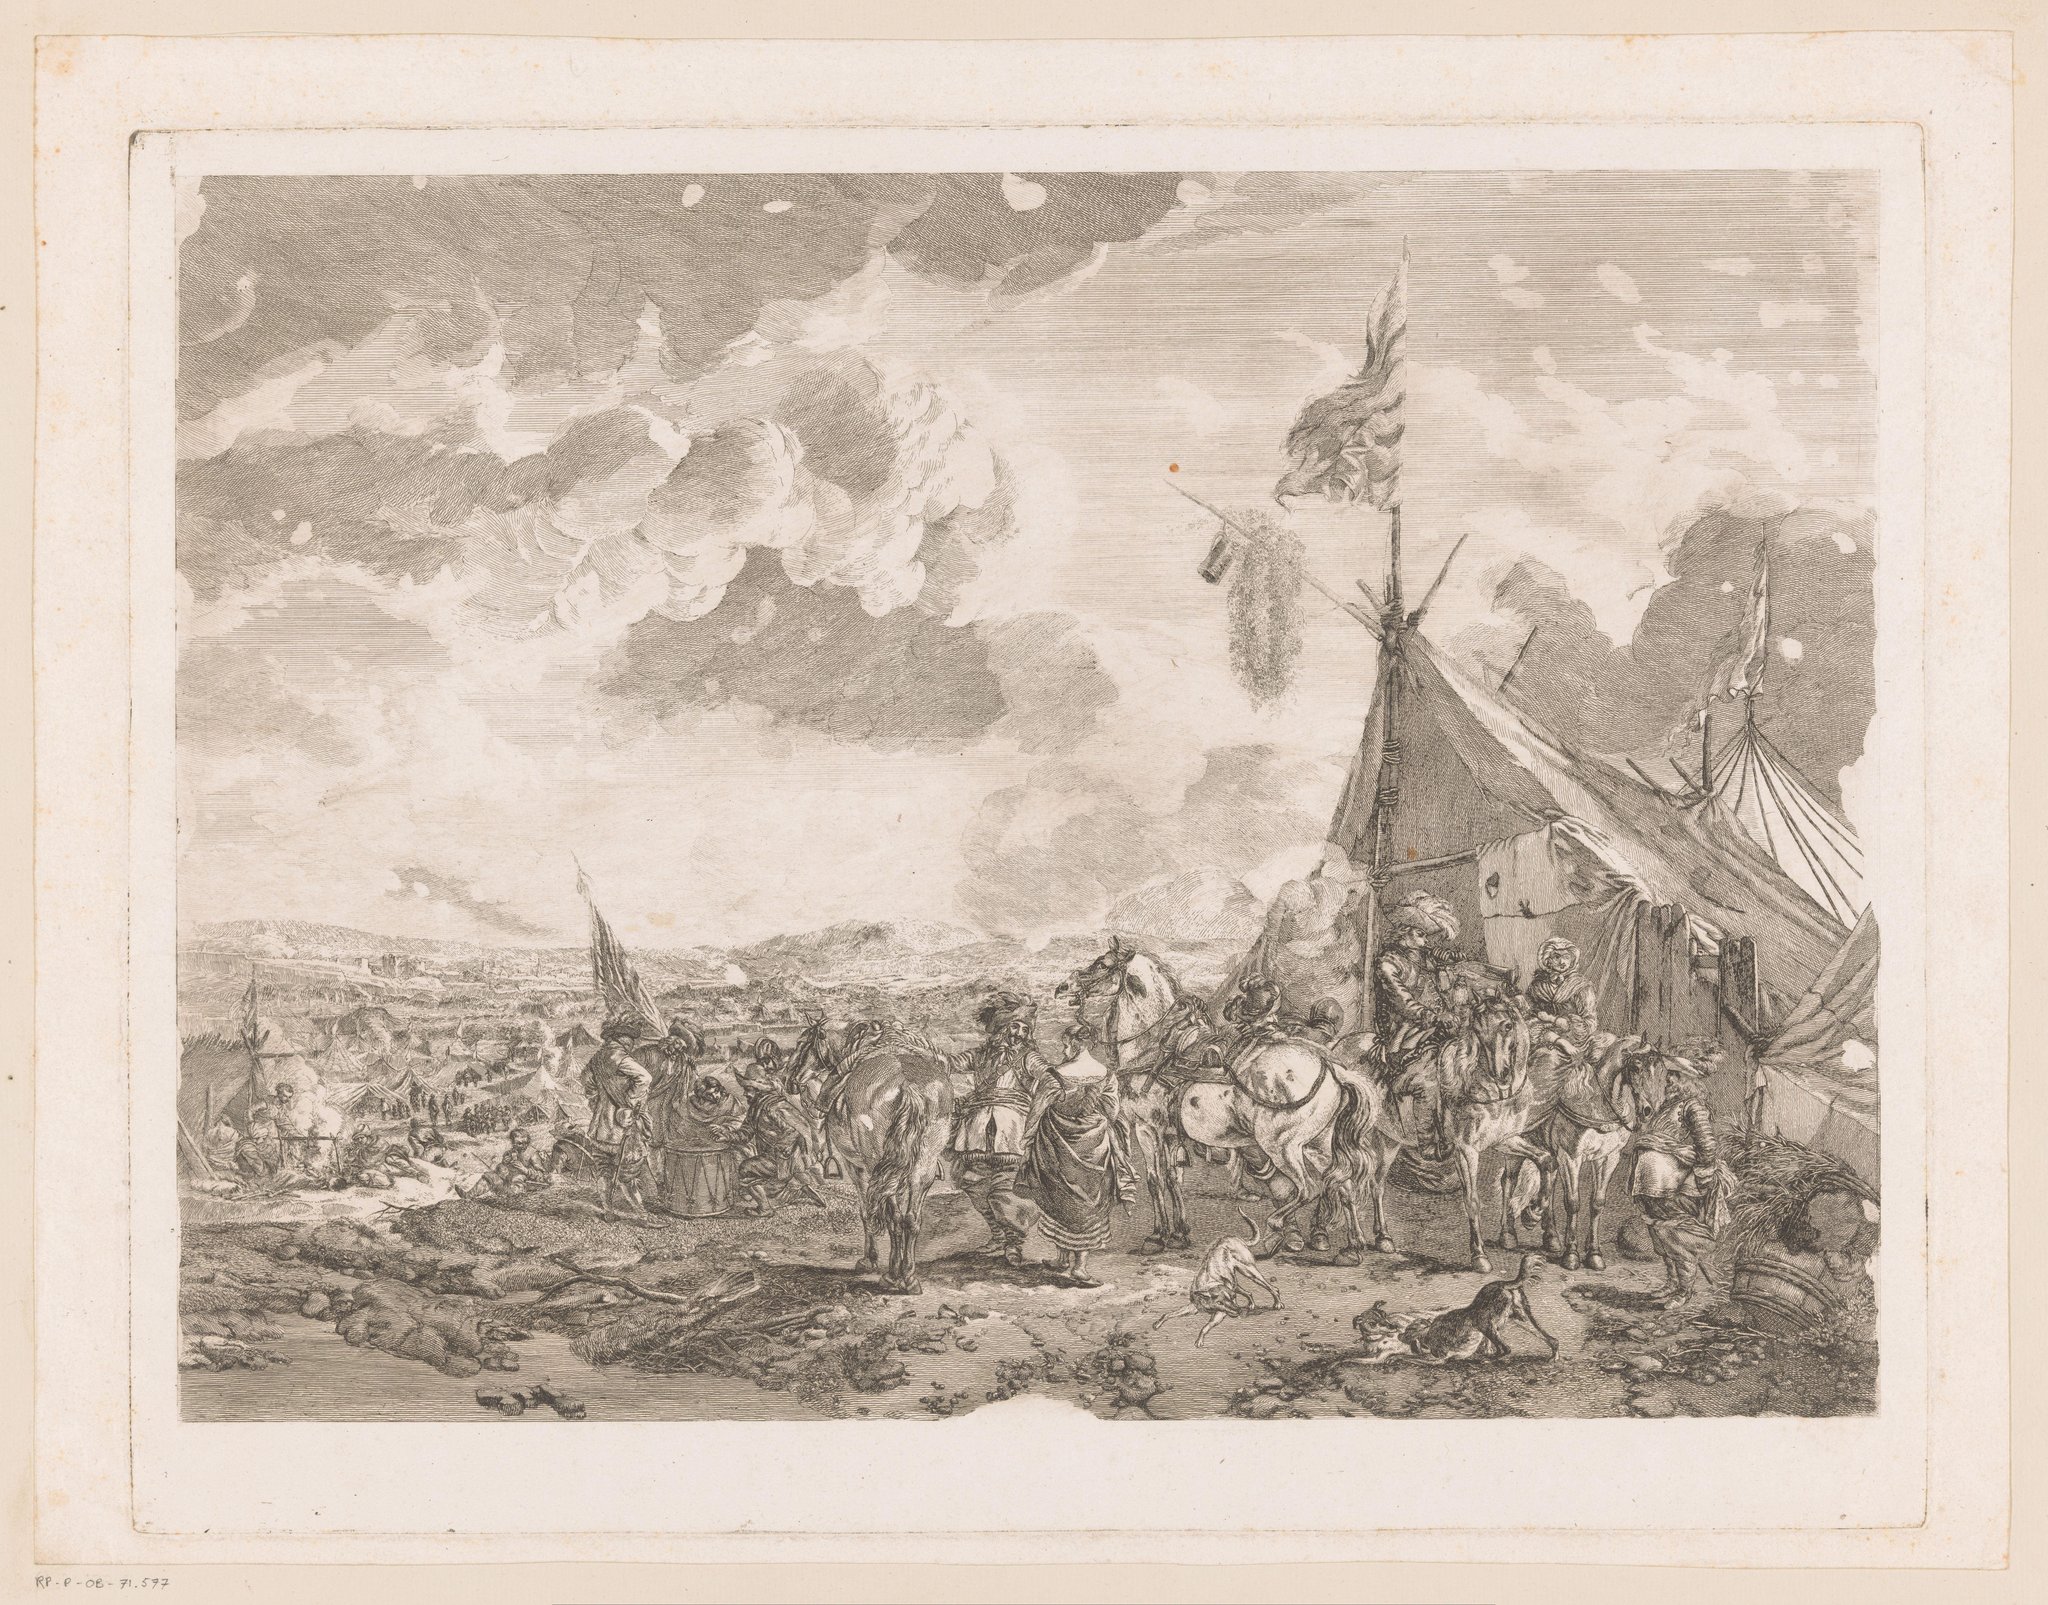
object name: print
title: Prenten naar schilderijen door Philips Wouwerman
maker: jean moyreau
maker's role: print maker, publisher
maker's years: 1690-1762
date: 1733-1762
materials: paper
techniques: etching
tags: (military) camp with tents, the soldier; the soldier's life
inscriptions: collector's mark: Lugt 240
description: Maakt deel uit van een serie van 89 prenten te dateren tussen ca. 1733-1762, naar het geschilderde oeuvre van Philips Wouwerman.